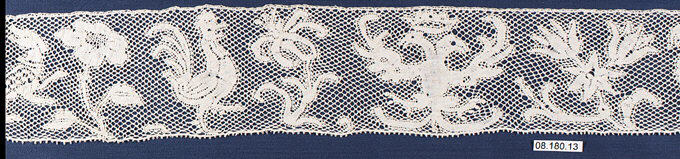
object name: border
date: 1701-1800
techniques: lace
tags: birds